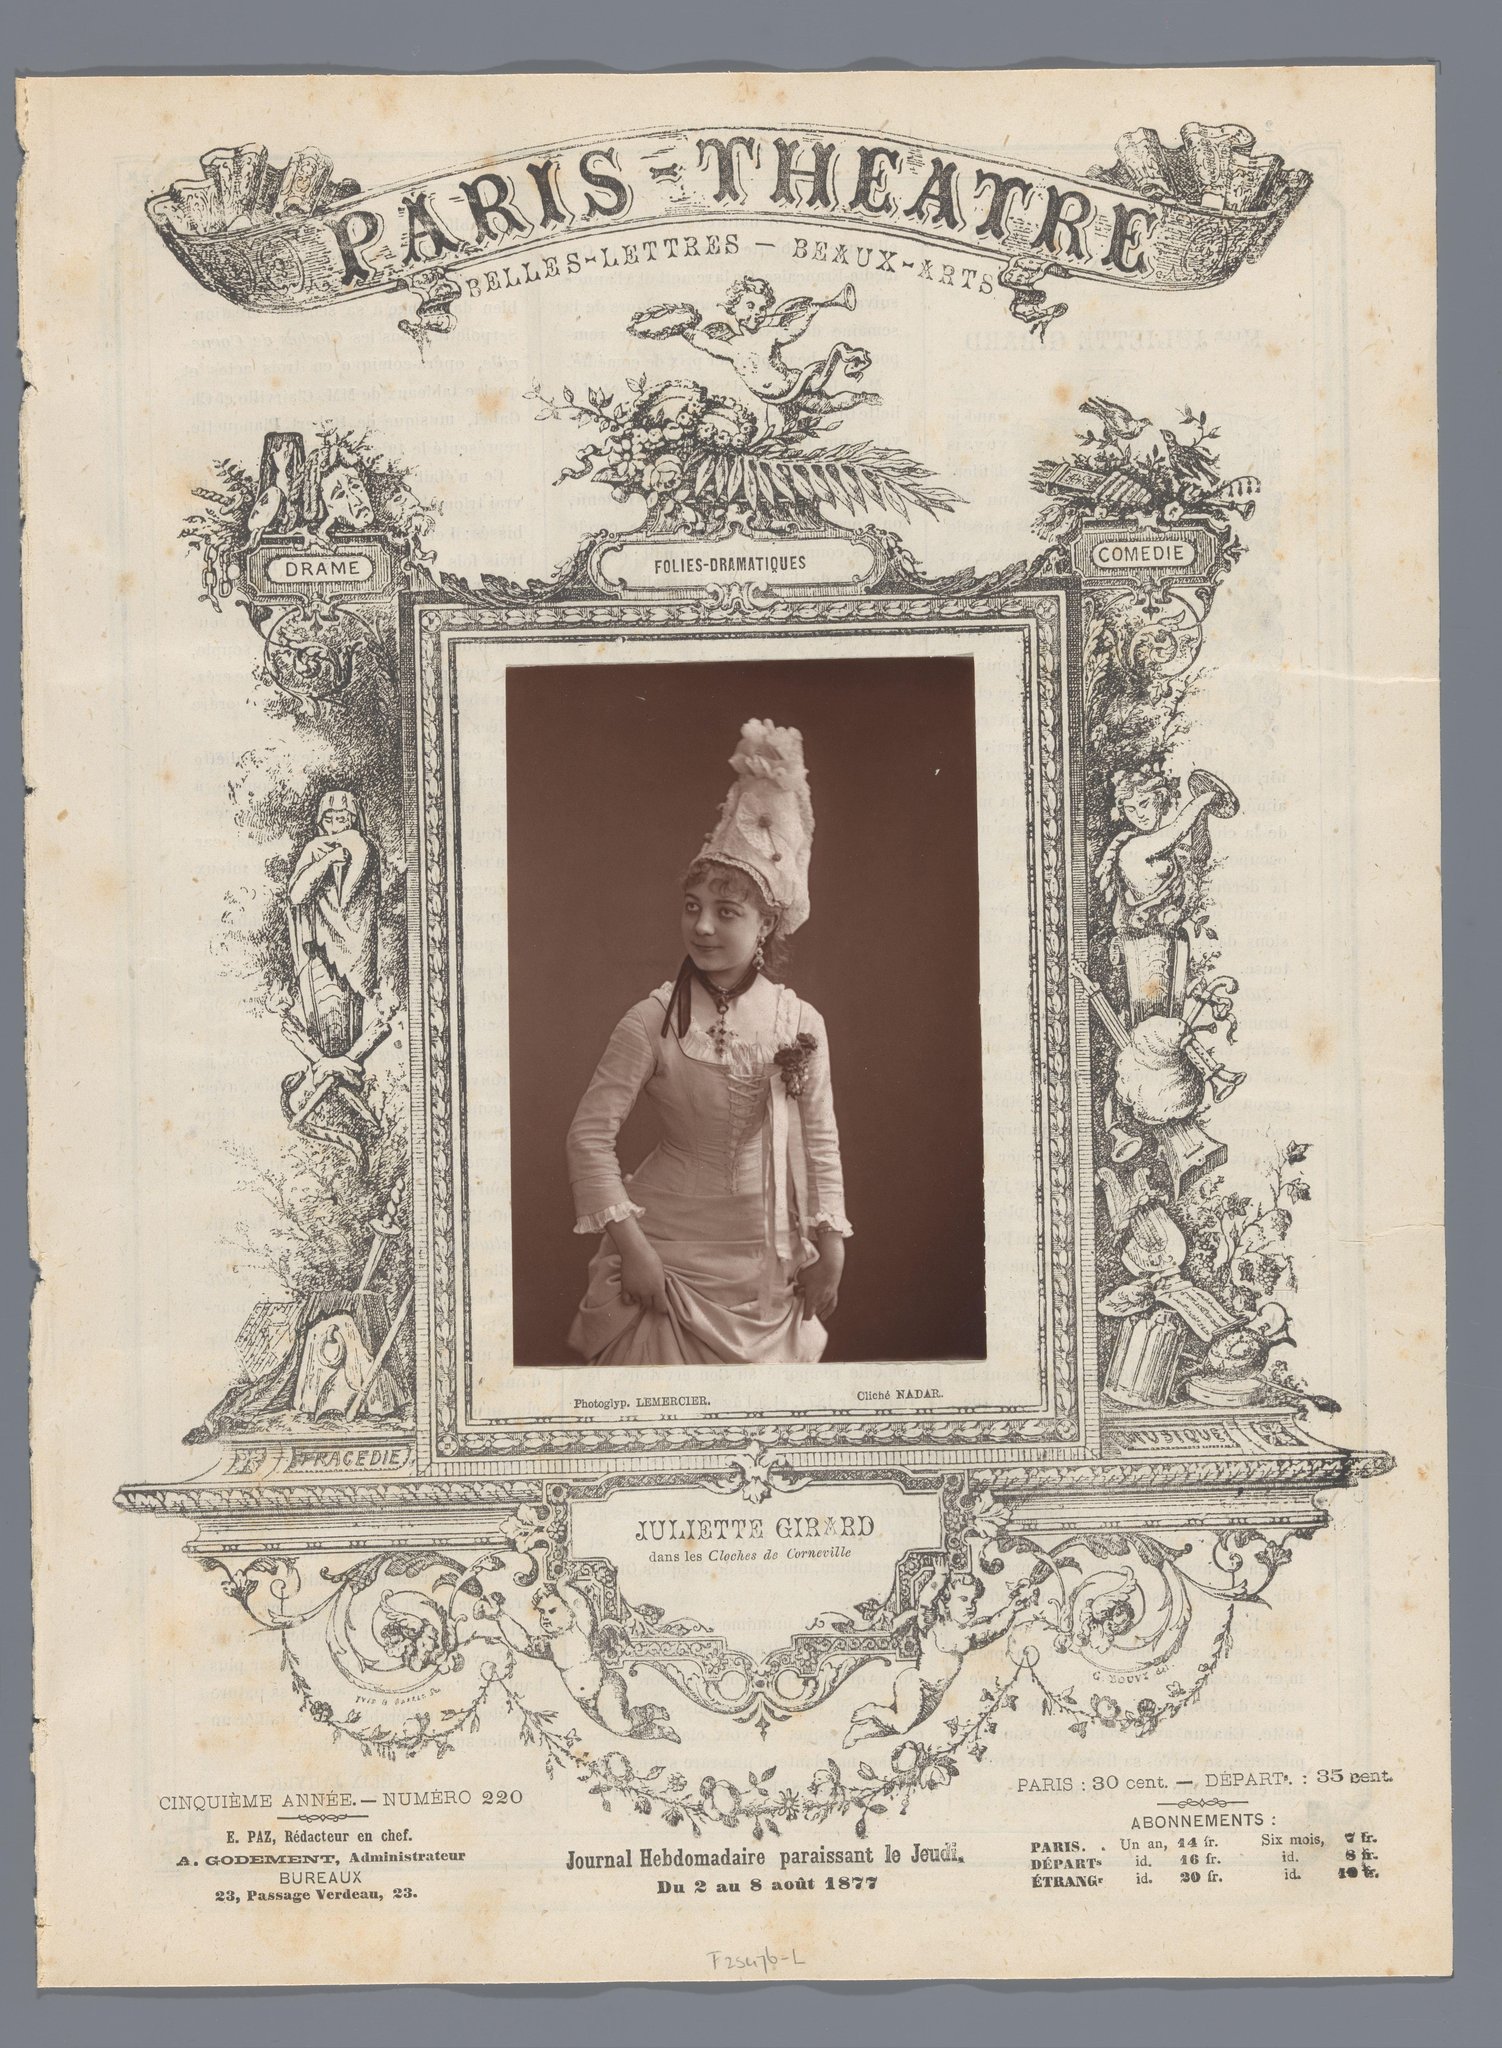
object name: photomechanical print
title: Portret van Juliette Girard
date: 1872-1879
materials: paper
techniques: woodburytype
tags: paris, historical persons - bb - woman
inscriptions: inscription: ‘dans les Cloches de Corneville’